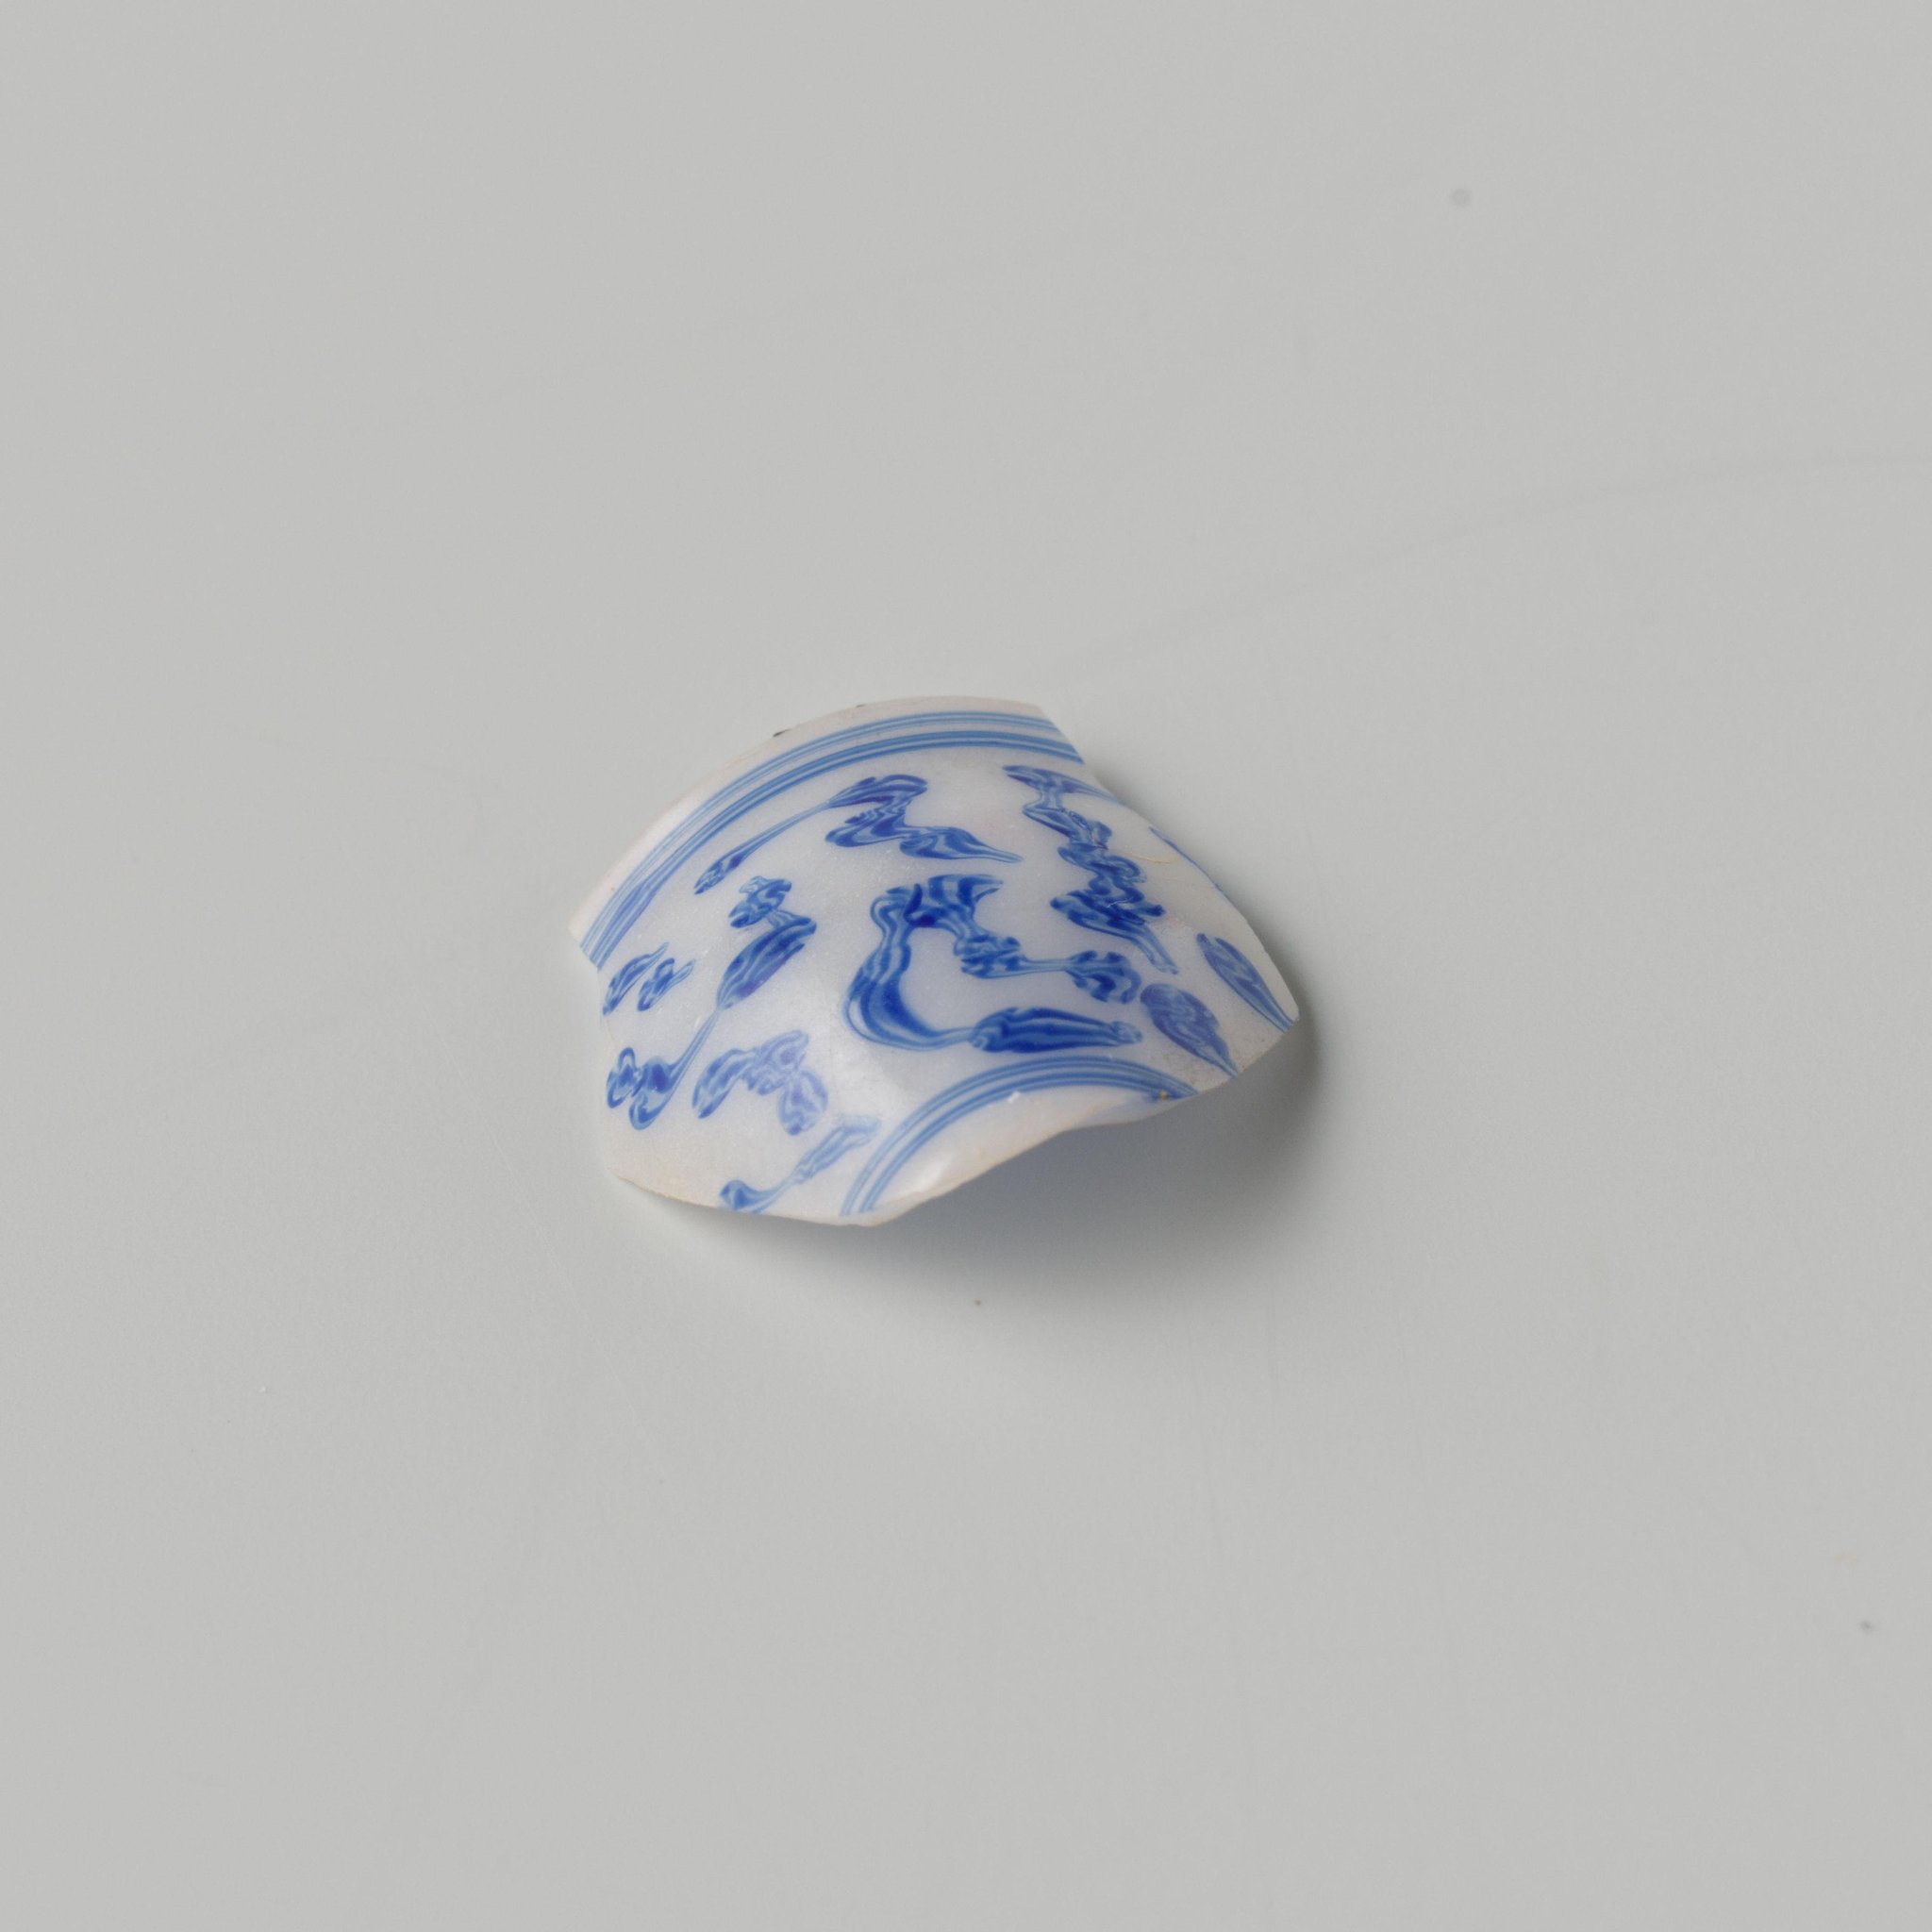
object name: sherd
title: Deel (scherf) van kopje van melkglas met blauwe emailverf beschildering, imitatie Chinees porselein met doorlopende versiering van ranken; gladde mondrand.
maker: Anonymous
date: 1675-1710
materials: glass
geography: amsterdam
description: Deel (scherf) van een kopje van melkglas met blauwe emailverf beschildering, imitatie Chinees blauw porselein met doorlopende versiering van ranken; gladde mondrand.